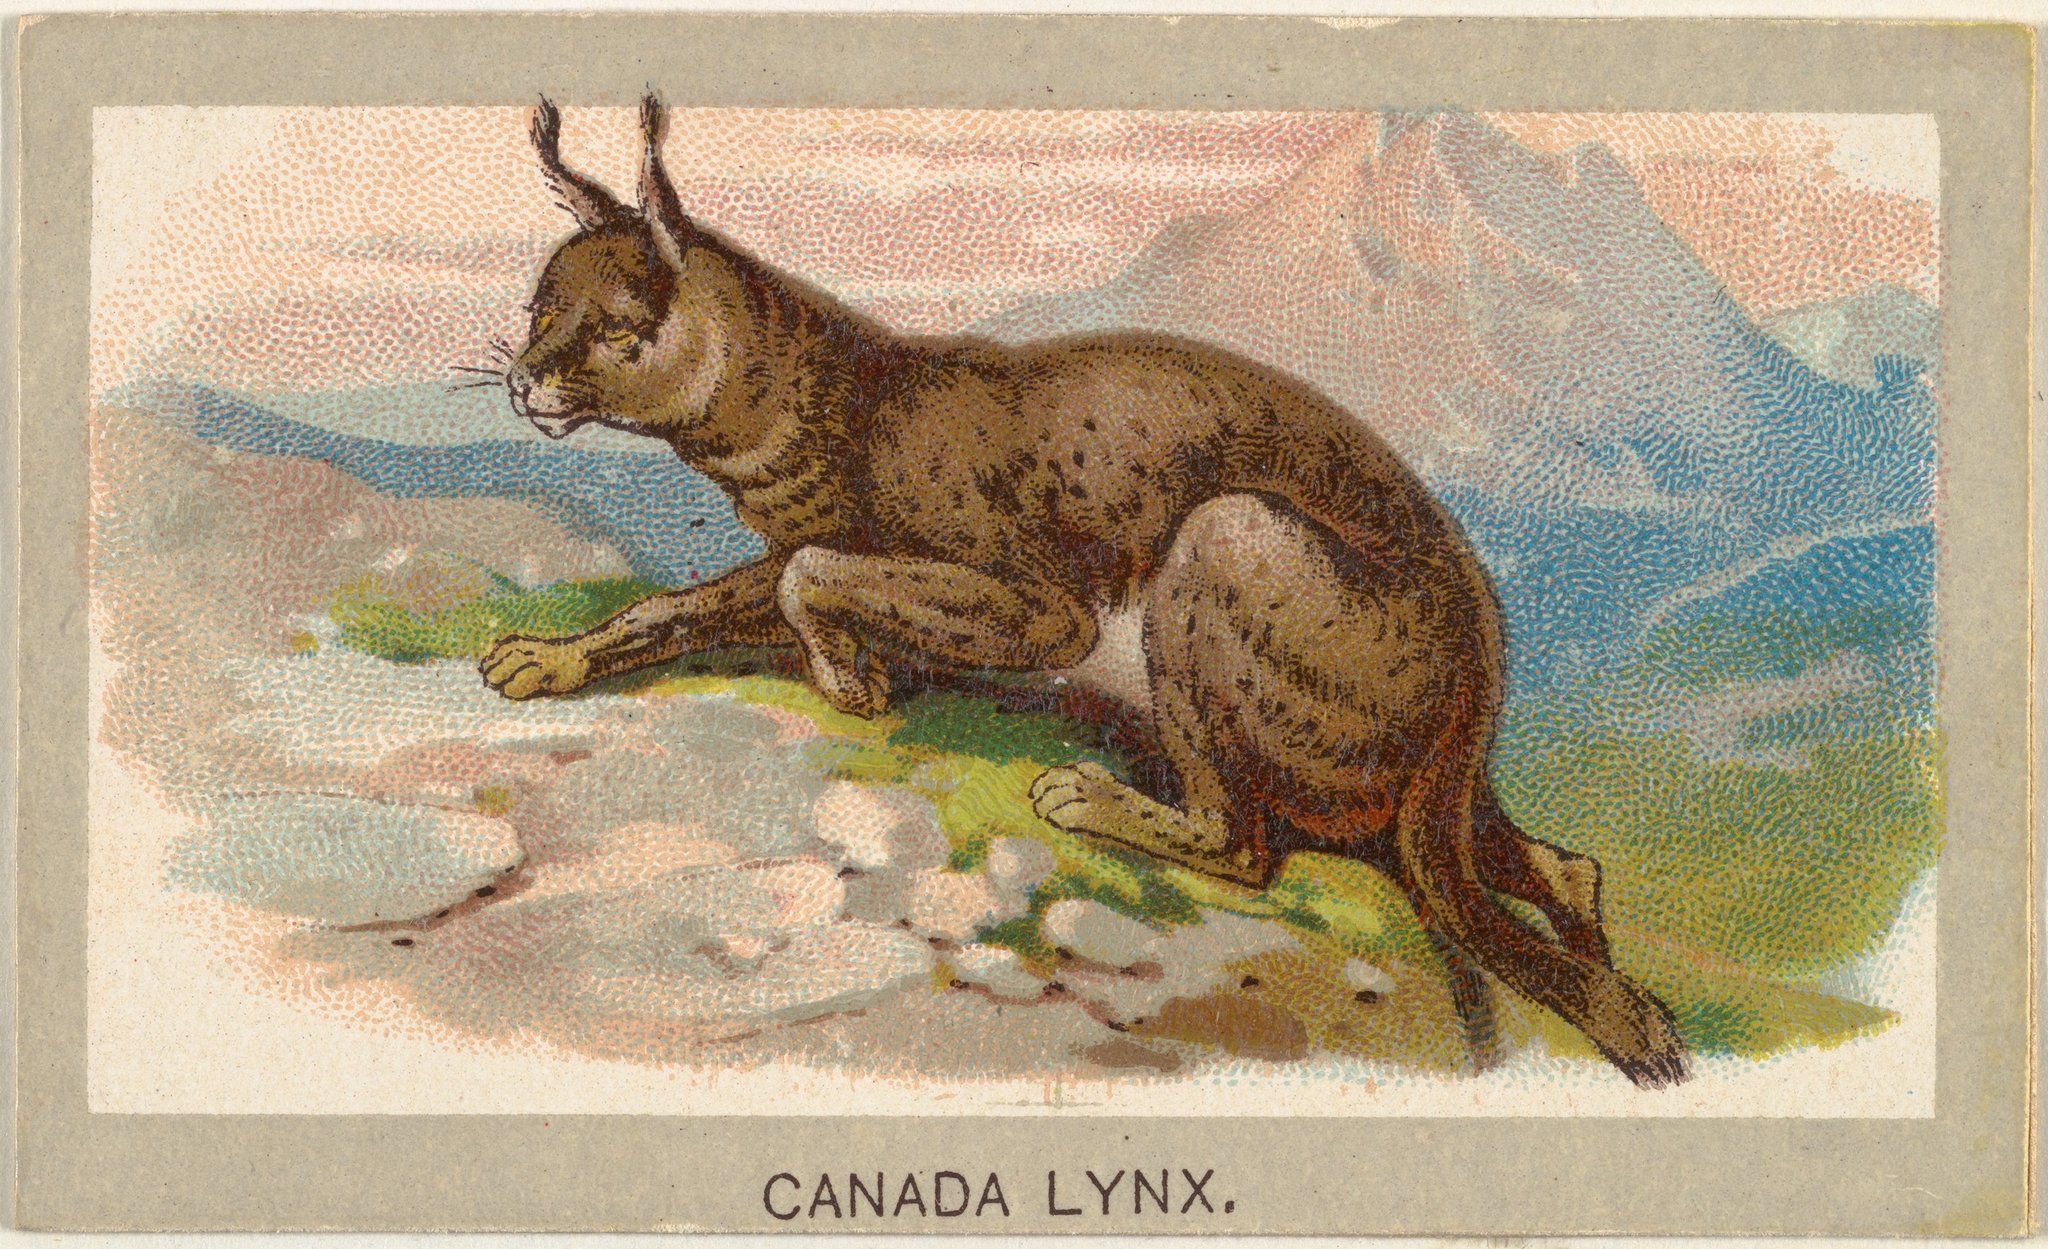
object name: print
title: Canada Lynx, from the Animals of the World series (T180), issued by Abdul Cigarettes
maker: abdul cigarettes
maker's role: publisher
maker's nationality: american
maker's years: 1881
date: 1881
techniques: color lithograph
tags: animals